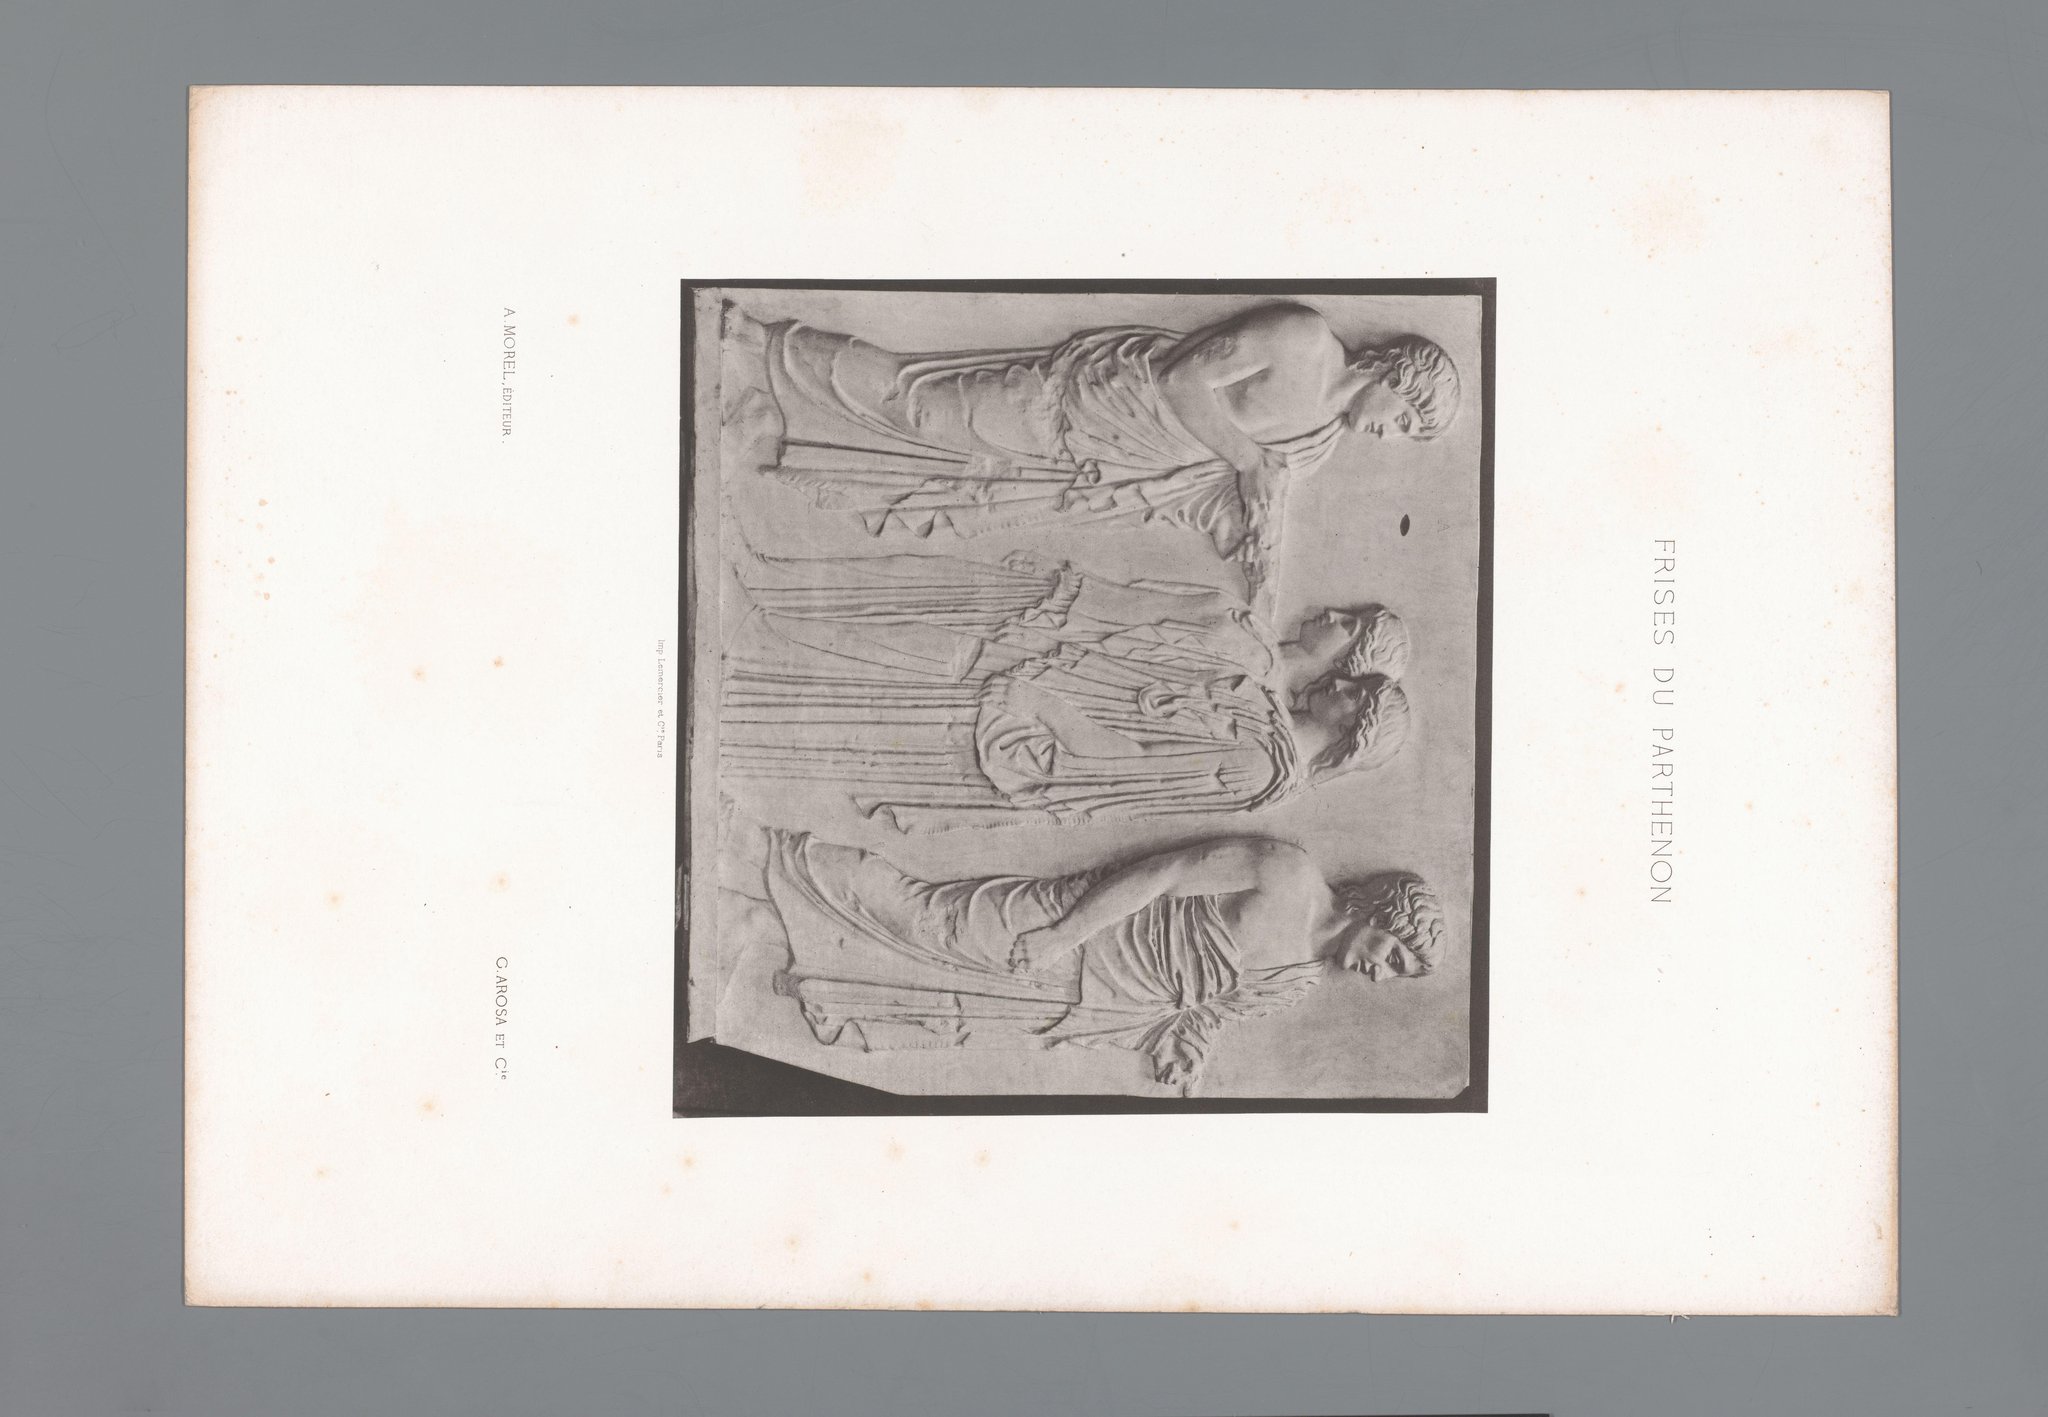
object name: photomechanical print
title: Frises du Parthenon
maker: a. morel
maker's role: publisher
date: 1863-1868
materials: paper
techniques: photograph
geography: paris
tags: adult man (+ two persons), mouldings ~ architecture, adult woman (+ two persons)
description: Deze prent maakt deel uit van een omslag met 22 prenten en 3 tekstbladen.